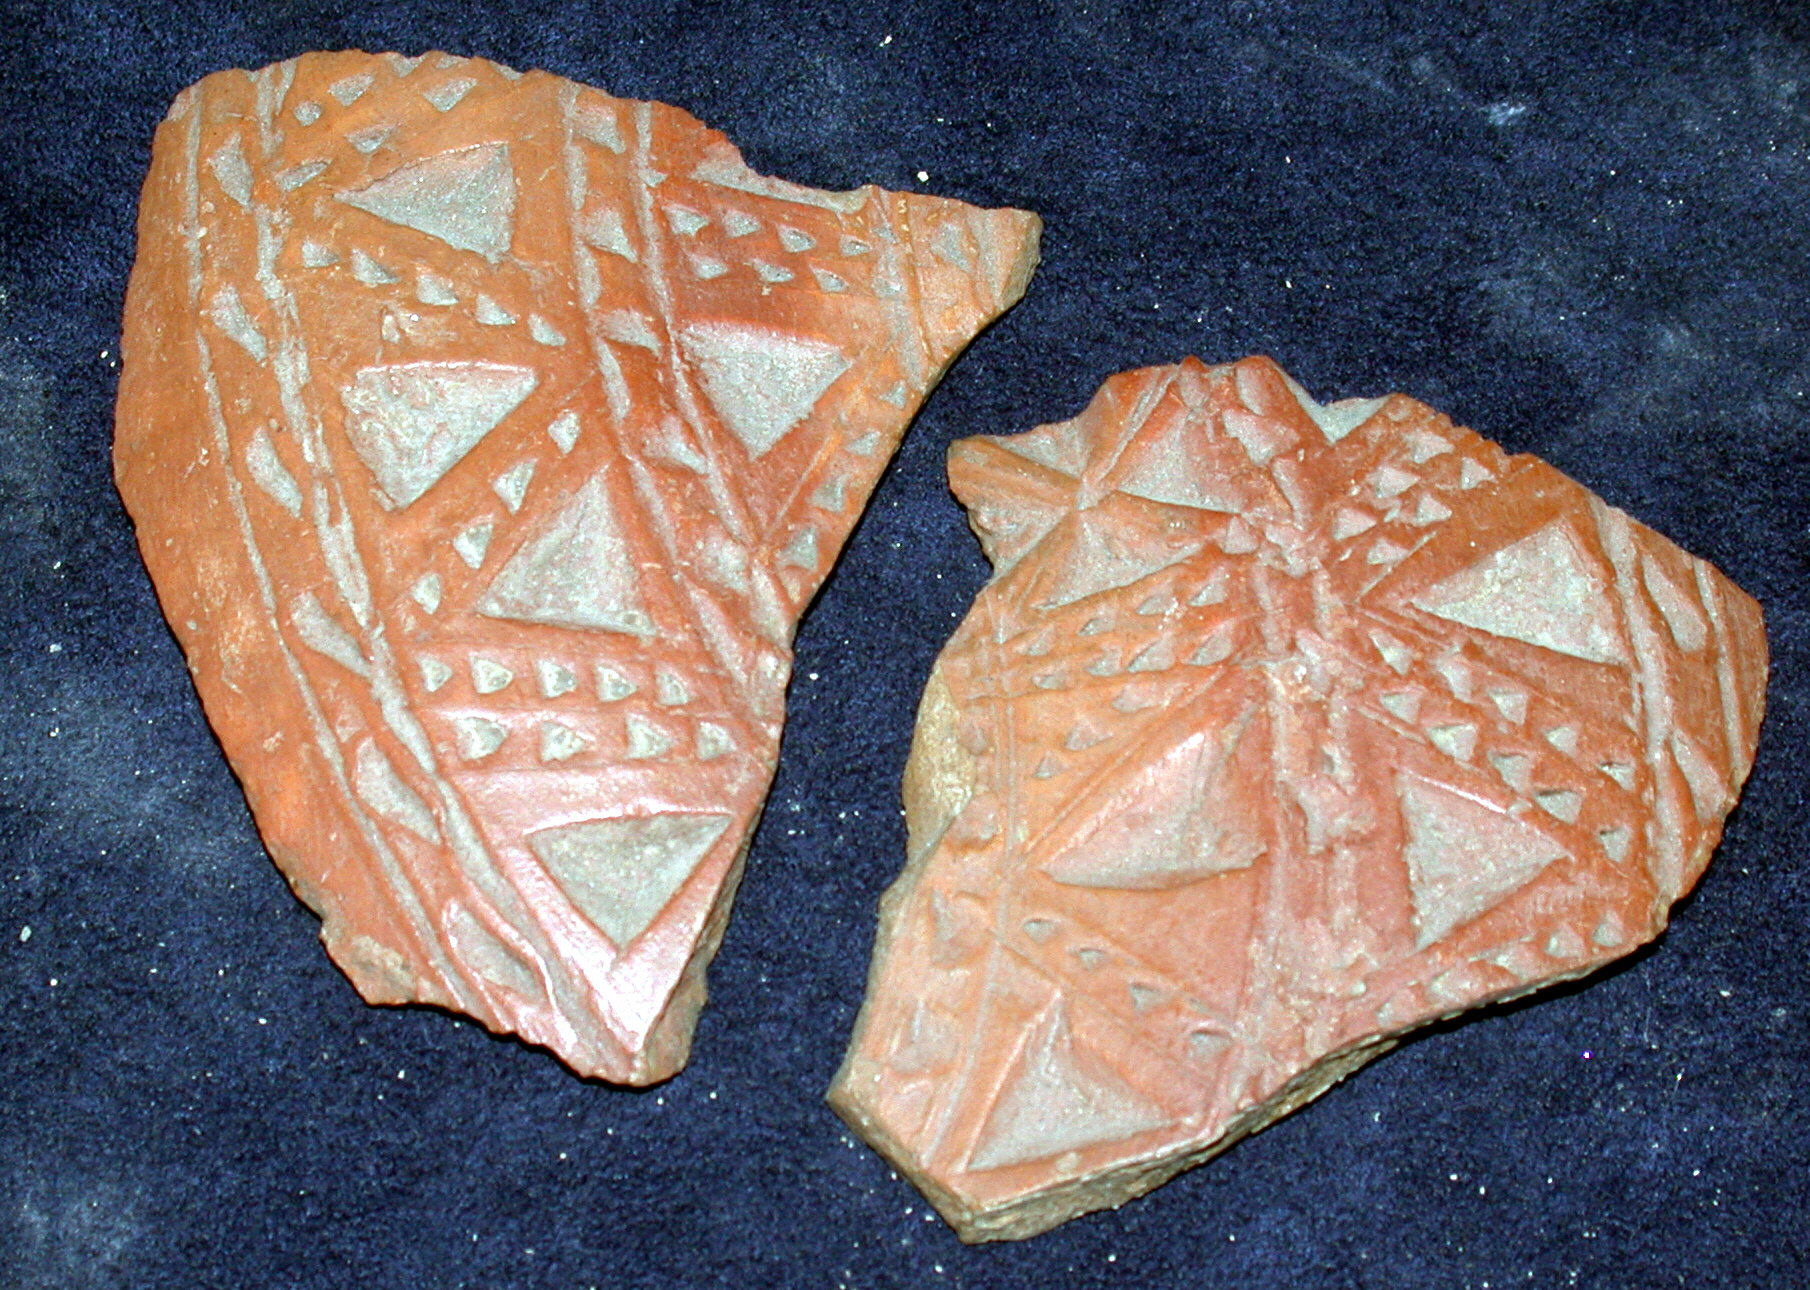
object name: sherd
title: Sherds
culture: sasanian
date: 201-700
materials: ceramic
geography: iran